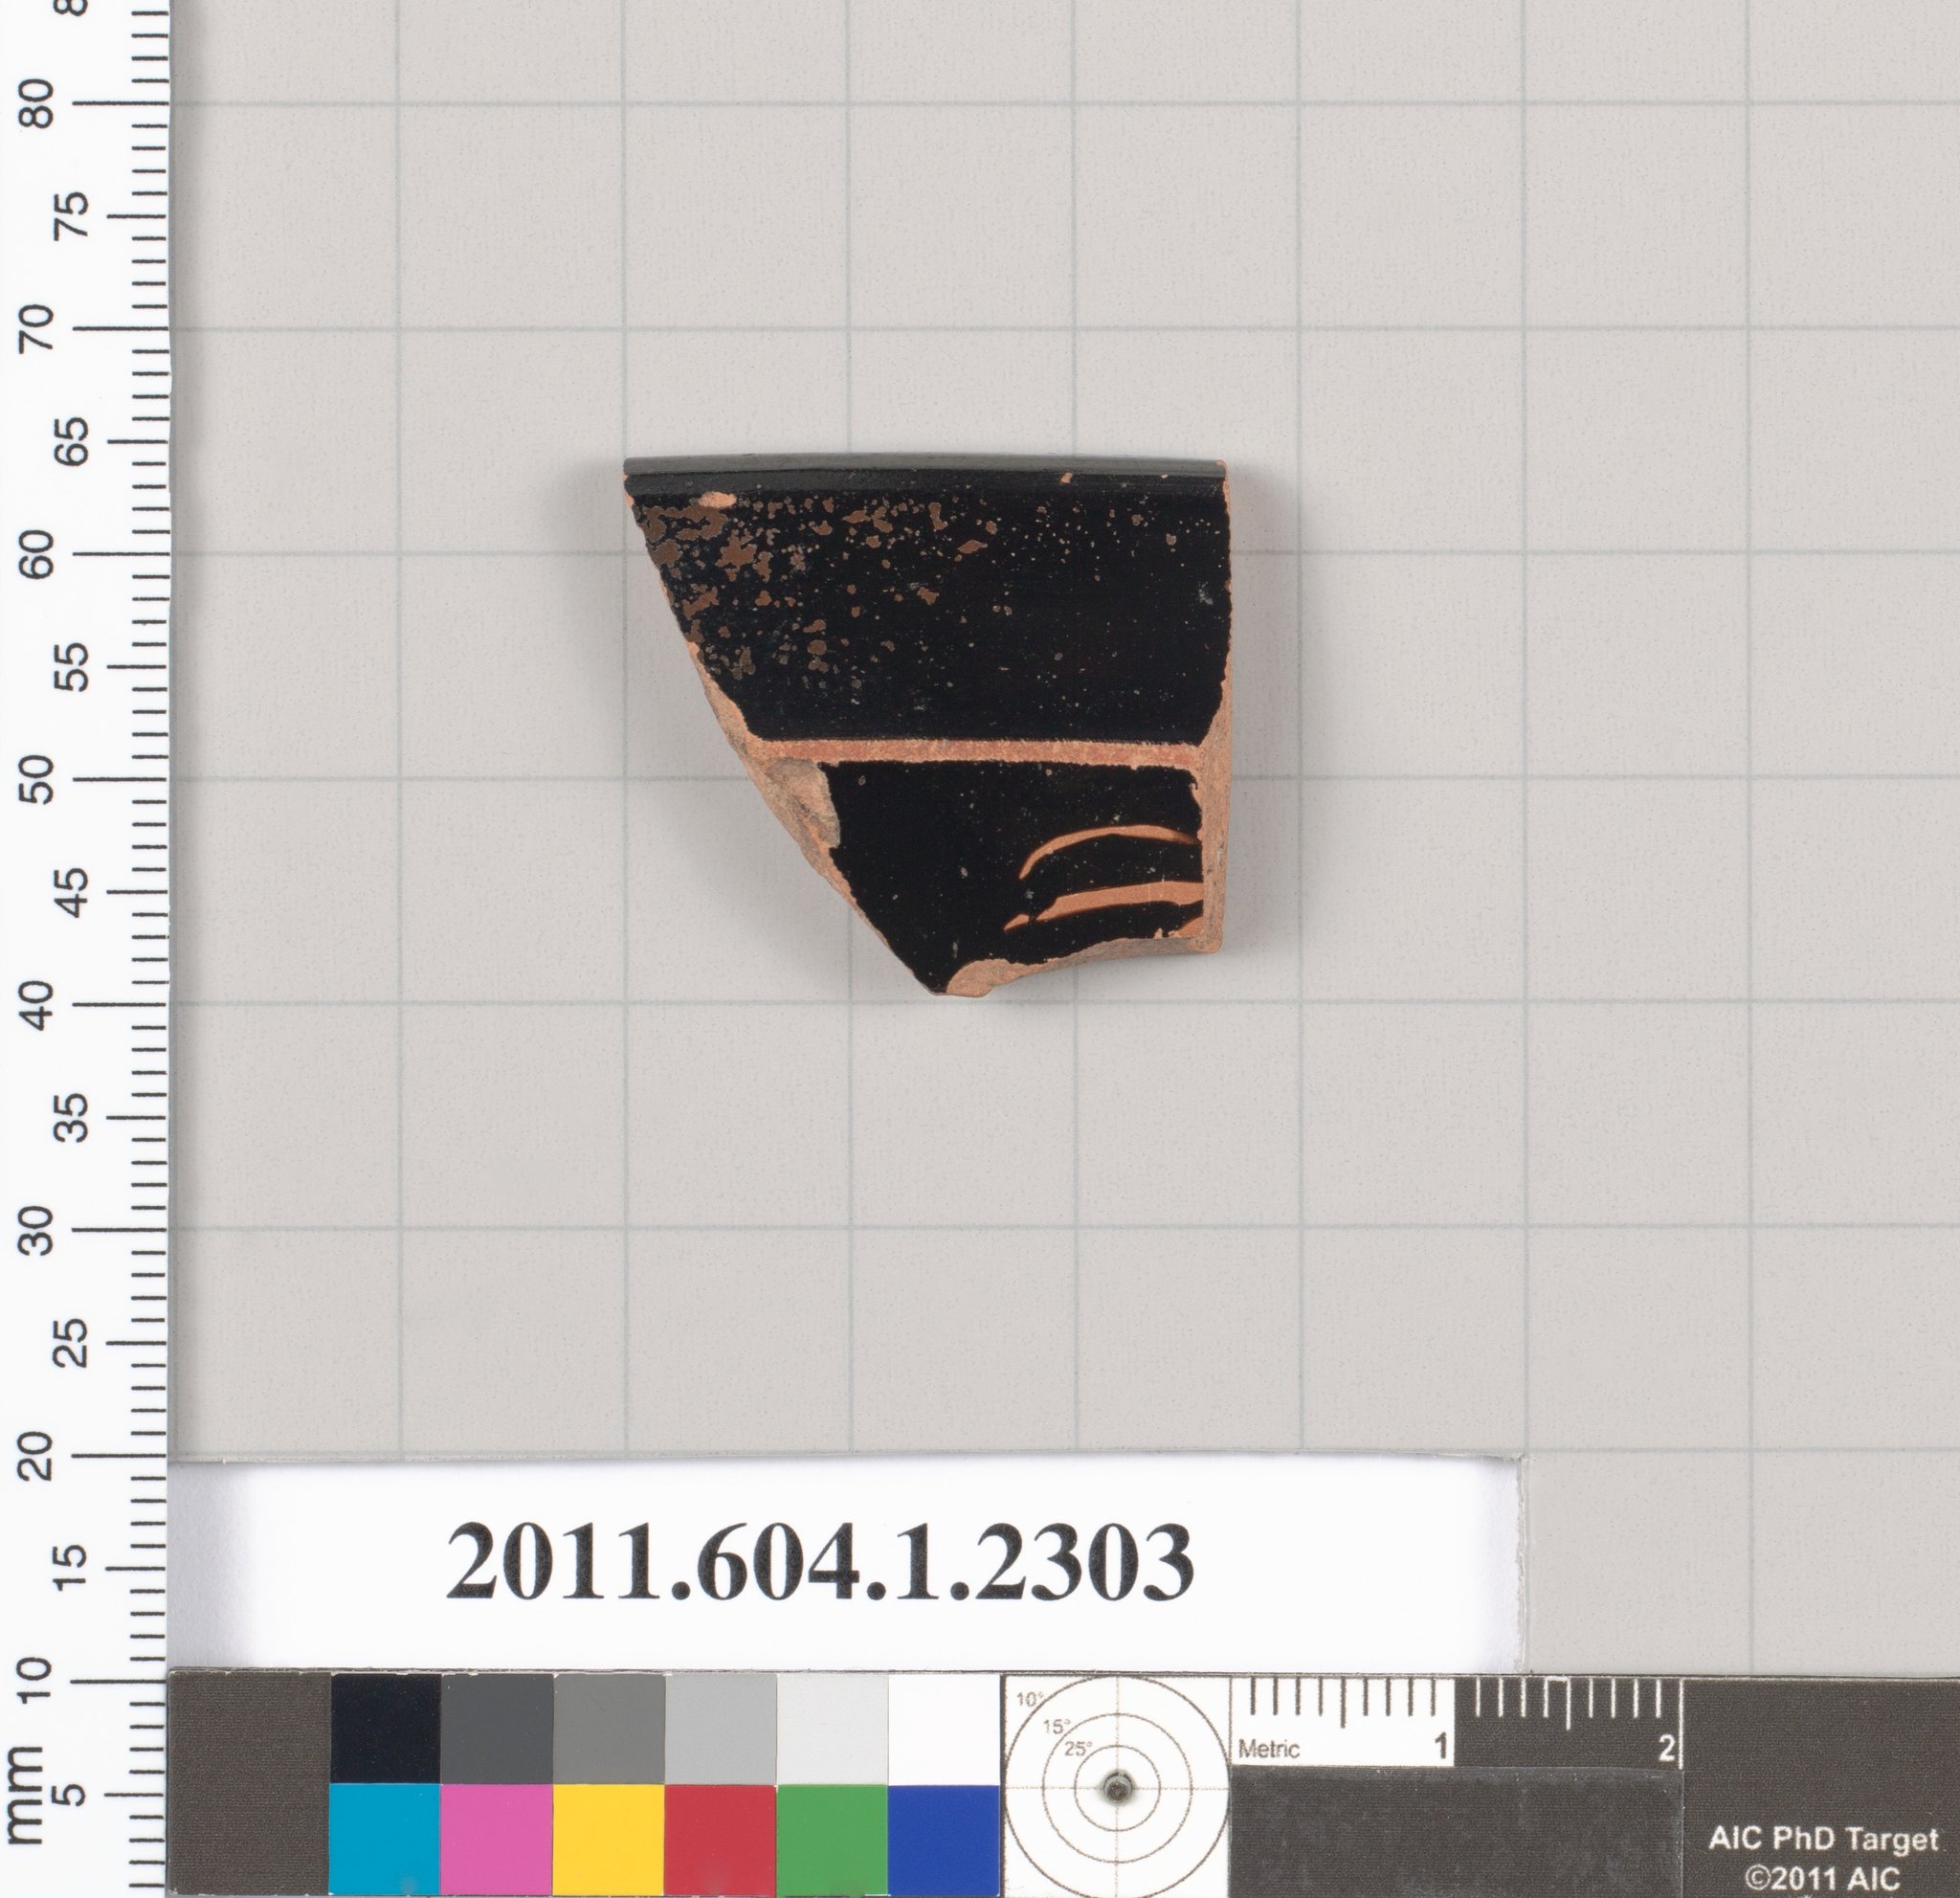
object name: kylix fragment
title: Terracotta rim fragment of a kylix (drinking cup)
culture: greek, attic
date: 475-451 BCE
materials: terracotta